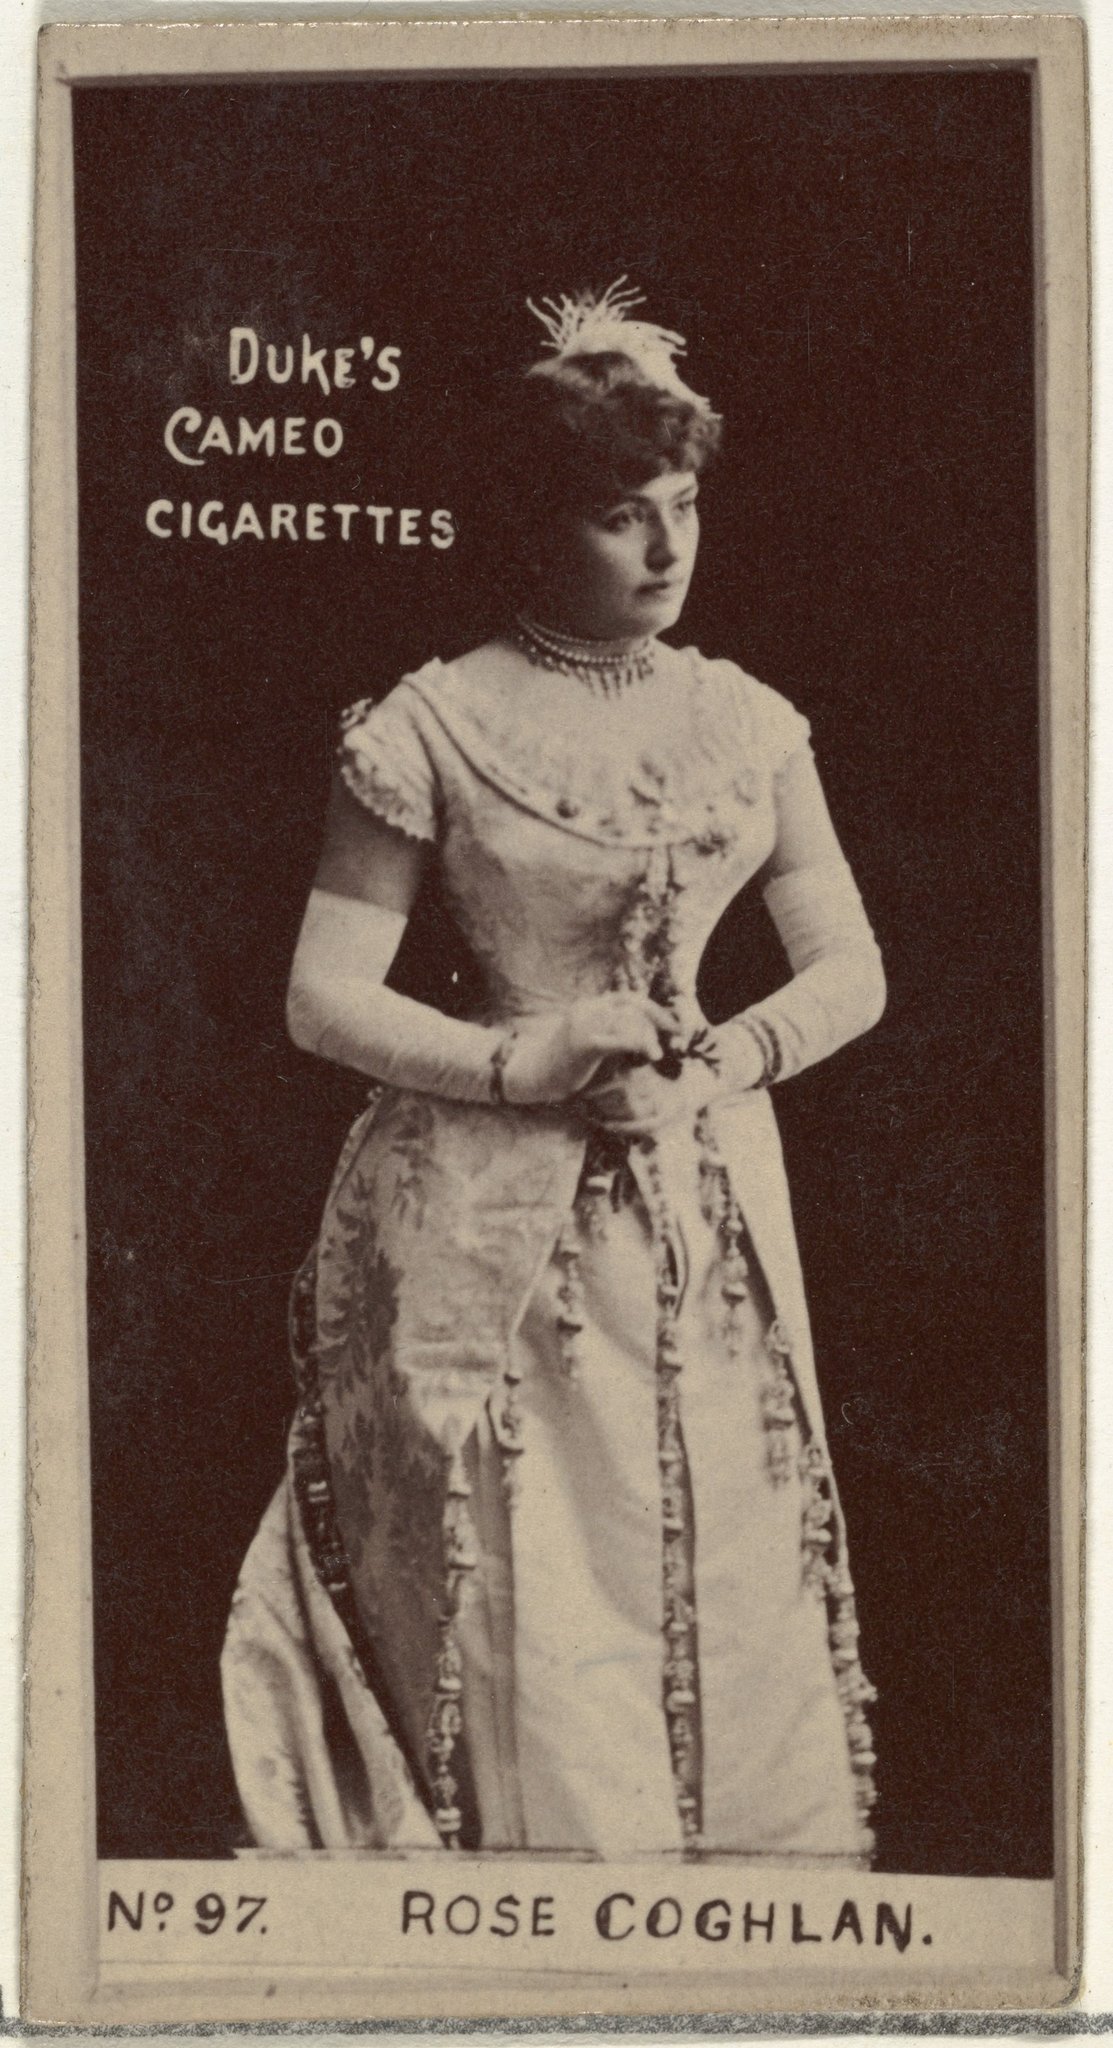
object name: photograph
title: Card Number 97, Rose Coghlan, from the Actors and Actresses series (N145-4) issued by Duke Sons & Co. to promote Cameo Cigarettes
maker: w. duke, sons & co.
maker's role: publisher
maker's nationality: american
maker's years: 1870-1920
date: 1880-1889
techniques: albumen silver print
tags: portraits,women,actresses